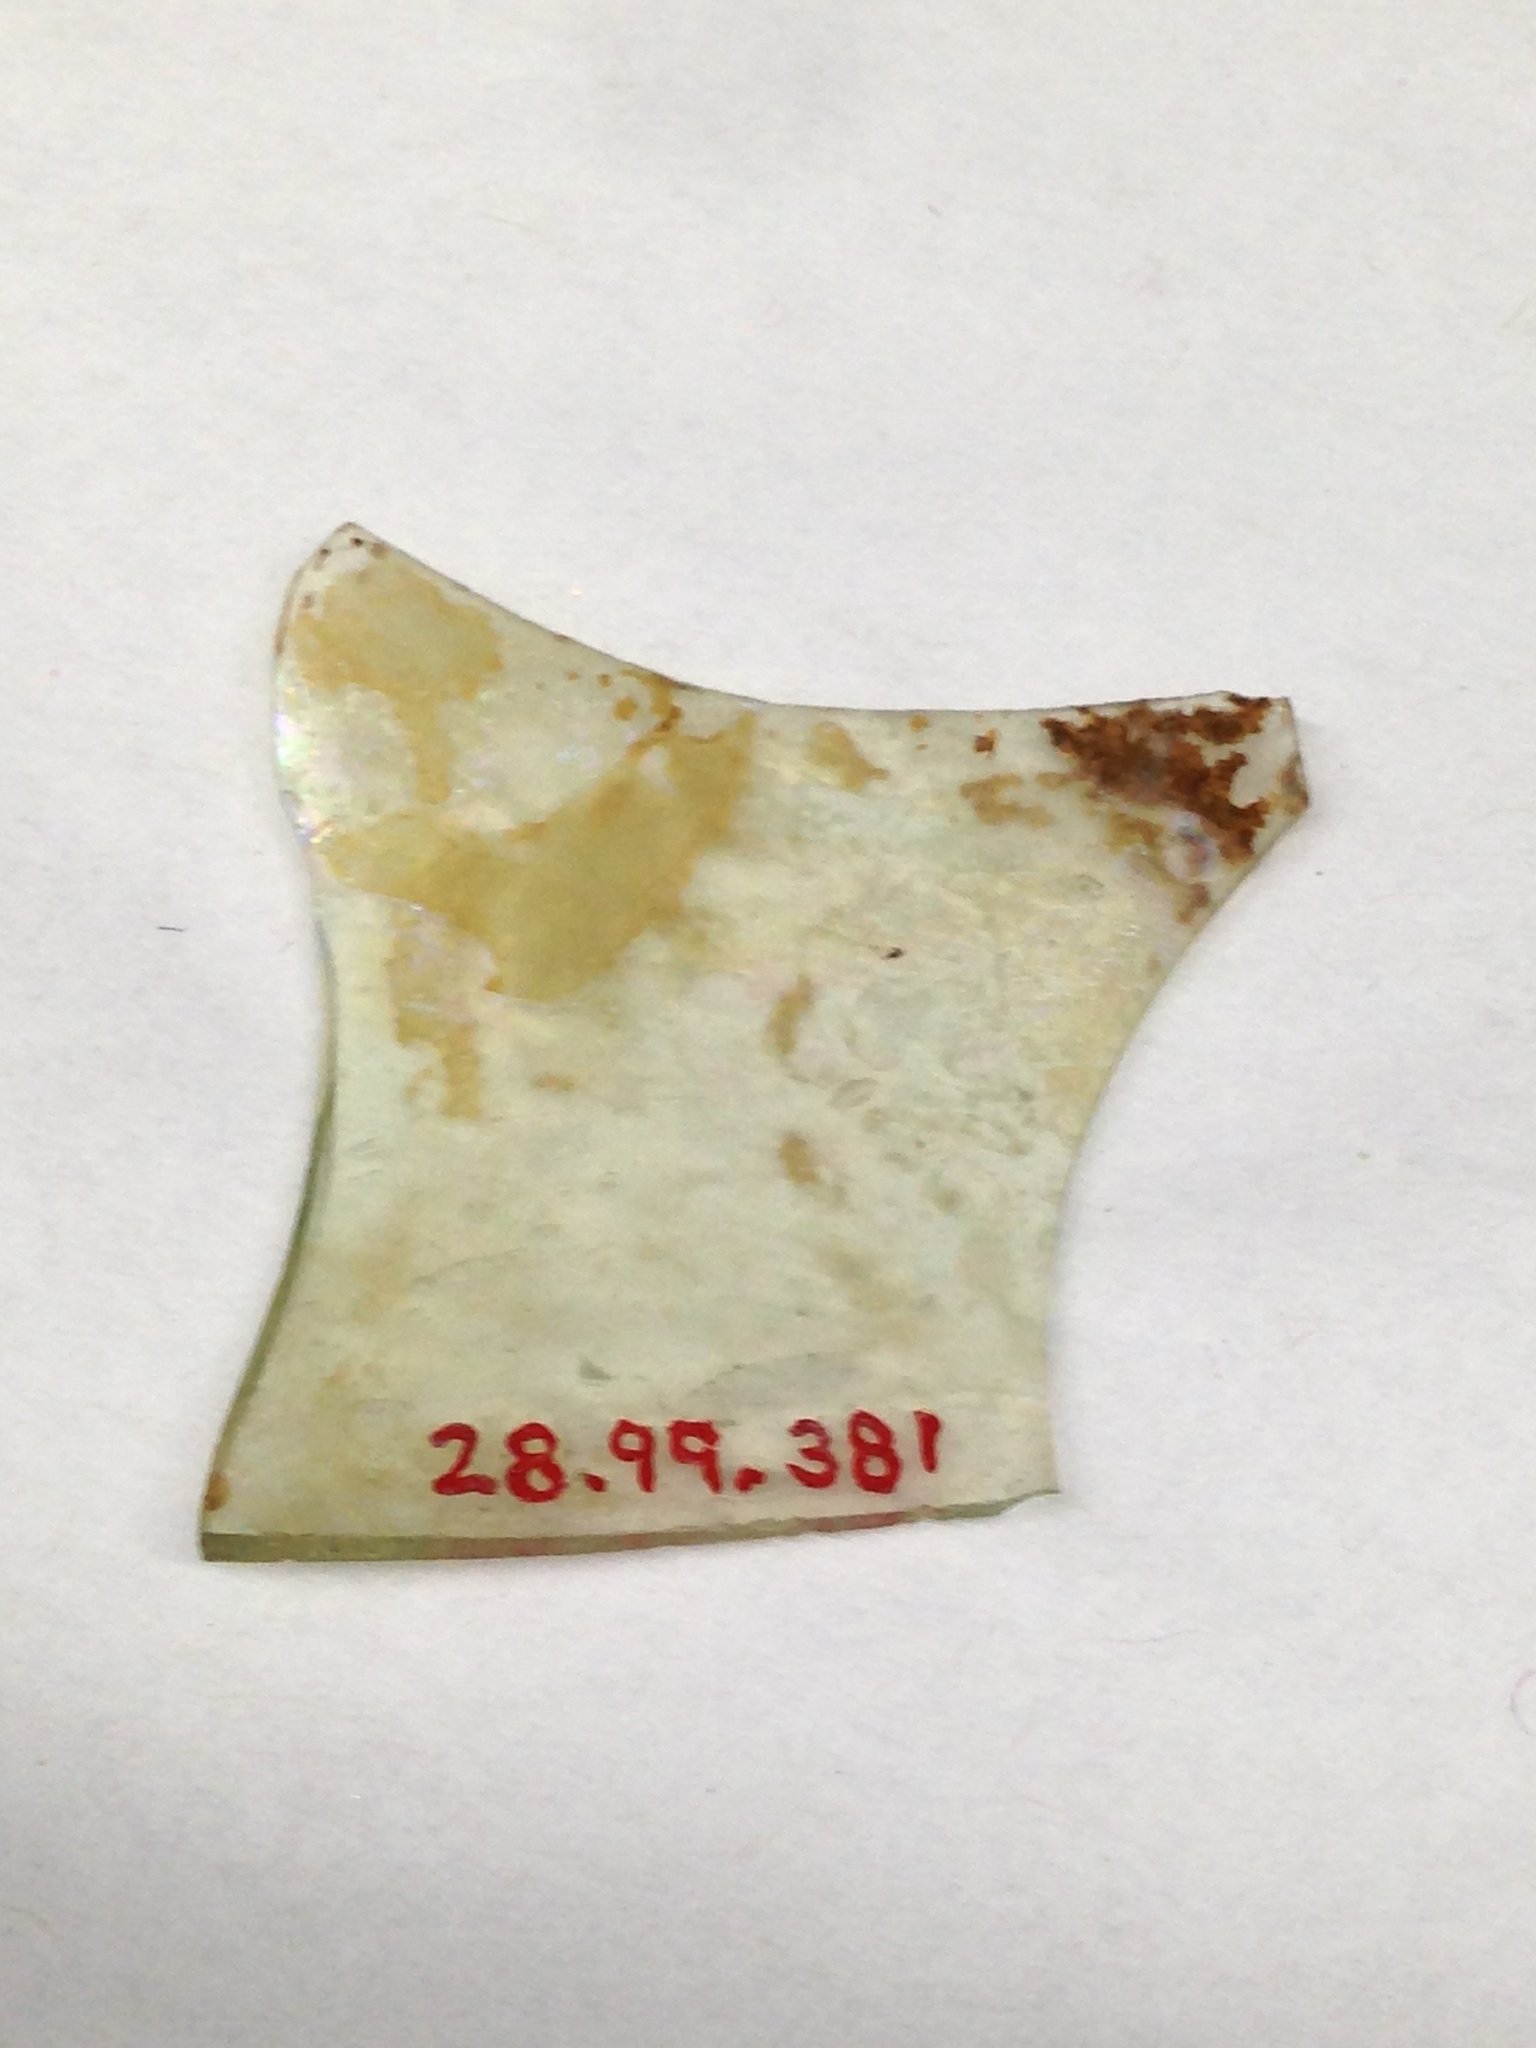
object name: fragment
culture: european or middle eastern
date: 1150-1250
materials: ceramic, glass